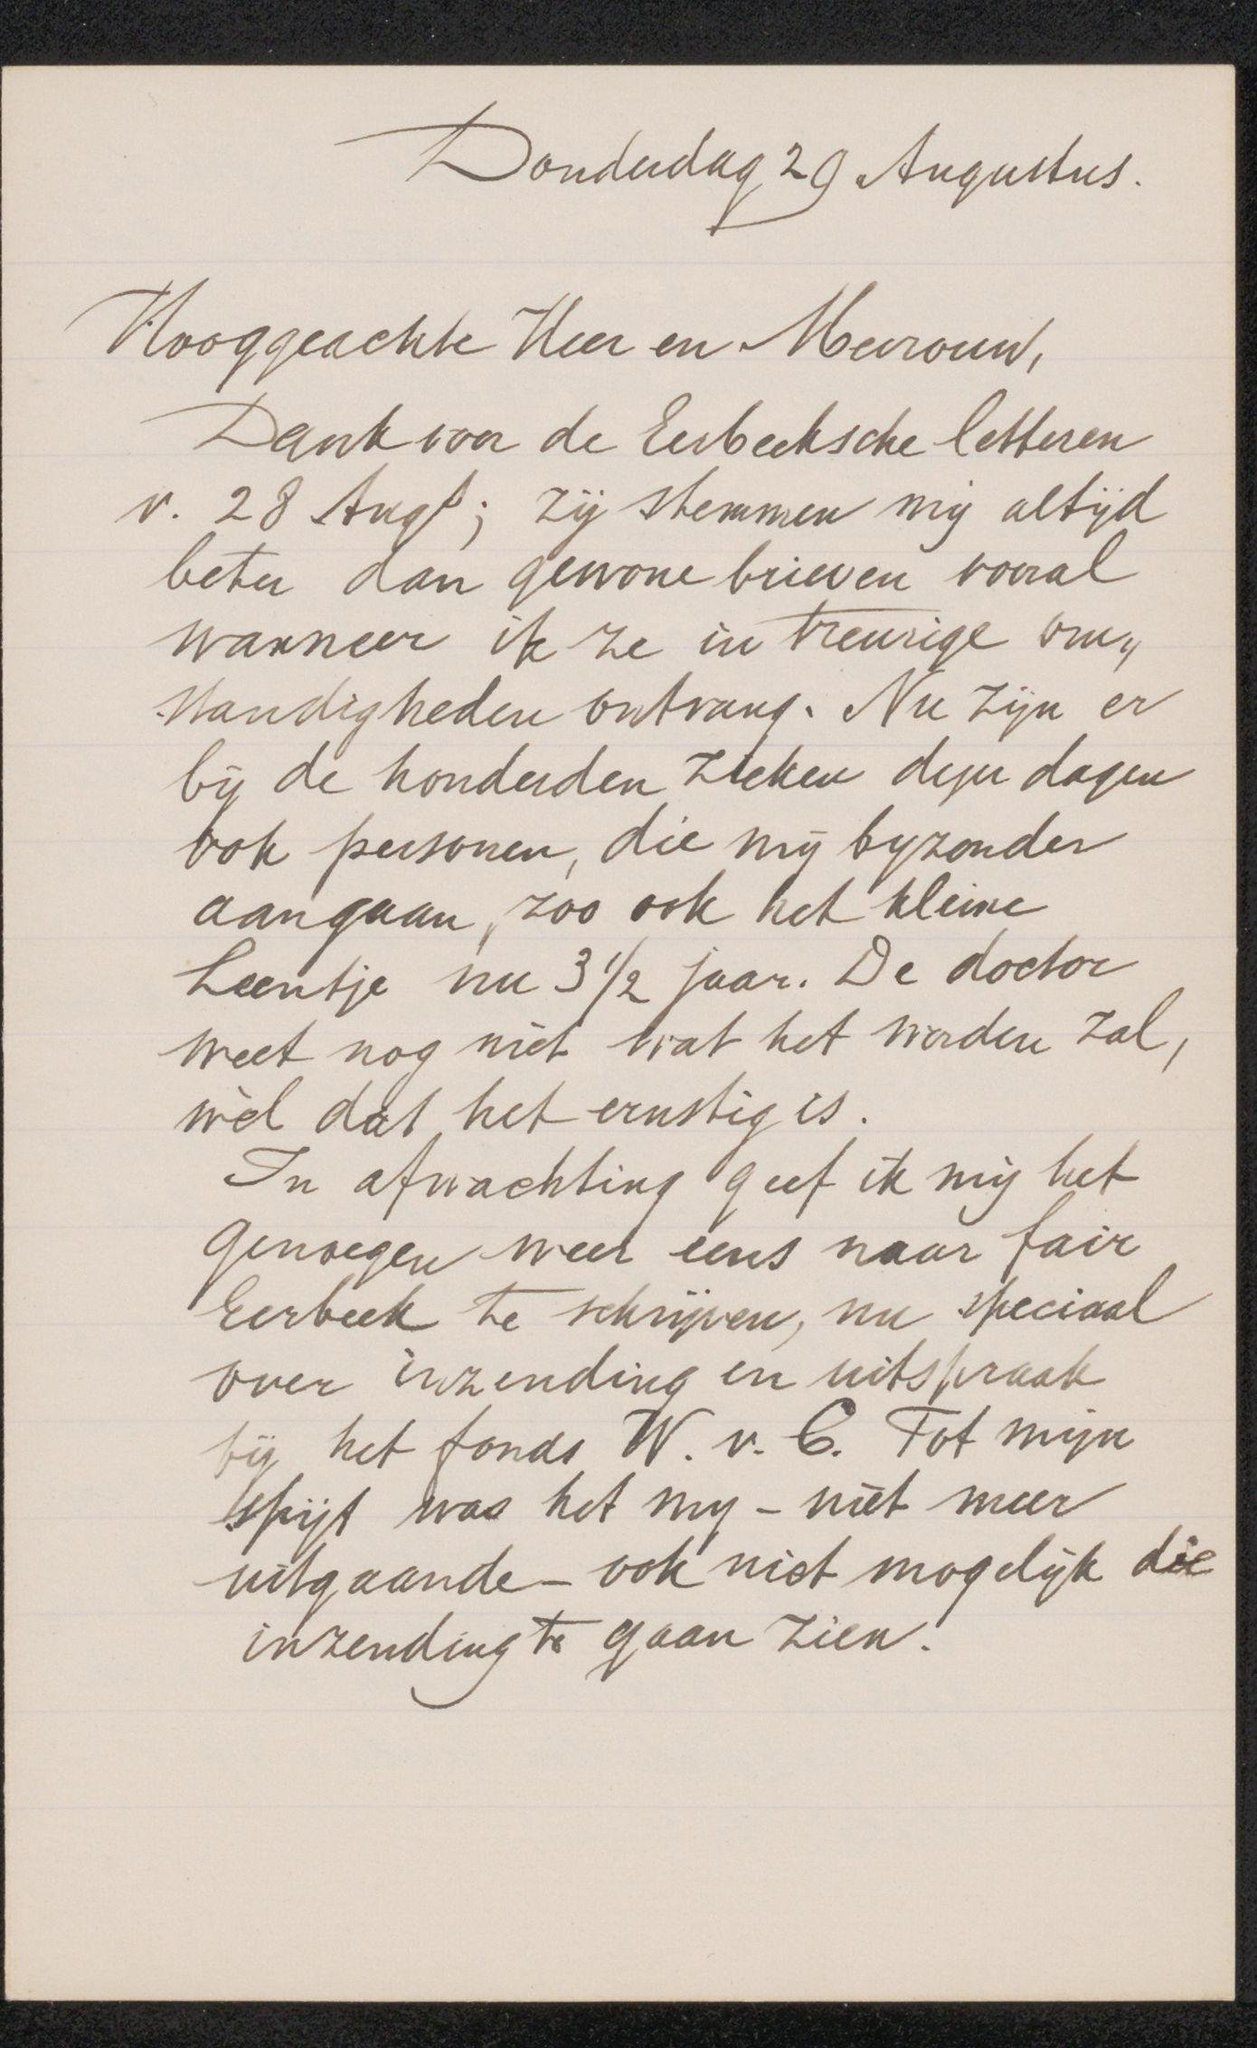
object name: letter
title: Brief aan Max Wilhelm Carl Weber en Anne Antoinette Weber-Van Bosse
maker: august allebé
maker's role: draughtsman, print maker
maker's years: 1838-1927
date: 1862-1927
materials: ink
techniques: pen, writing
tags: anne antoinette weber-van bosse, wilhelm ferdinand willink van collen, john ruskin, money